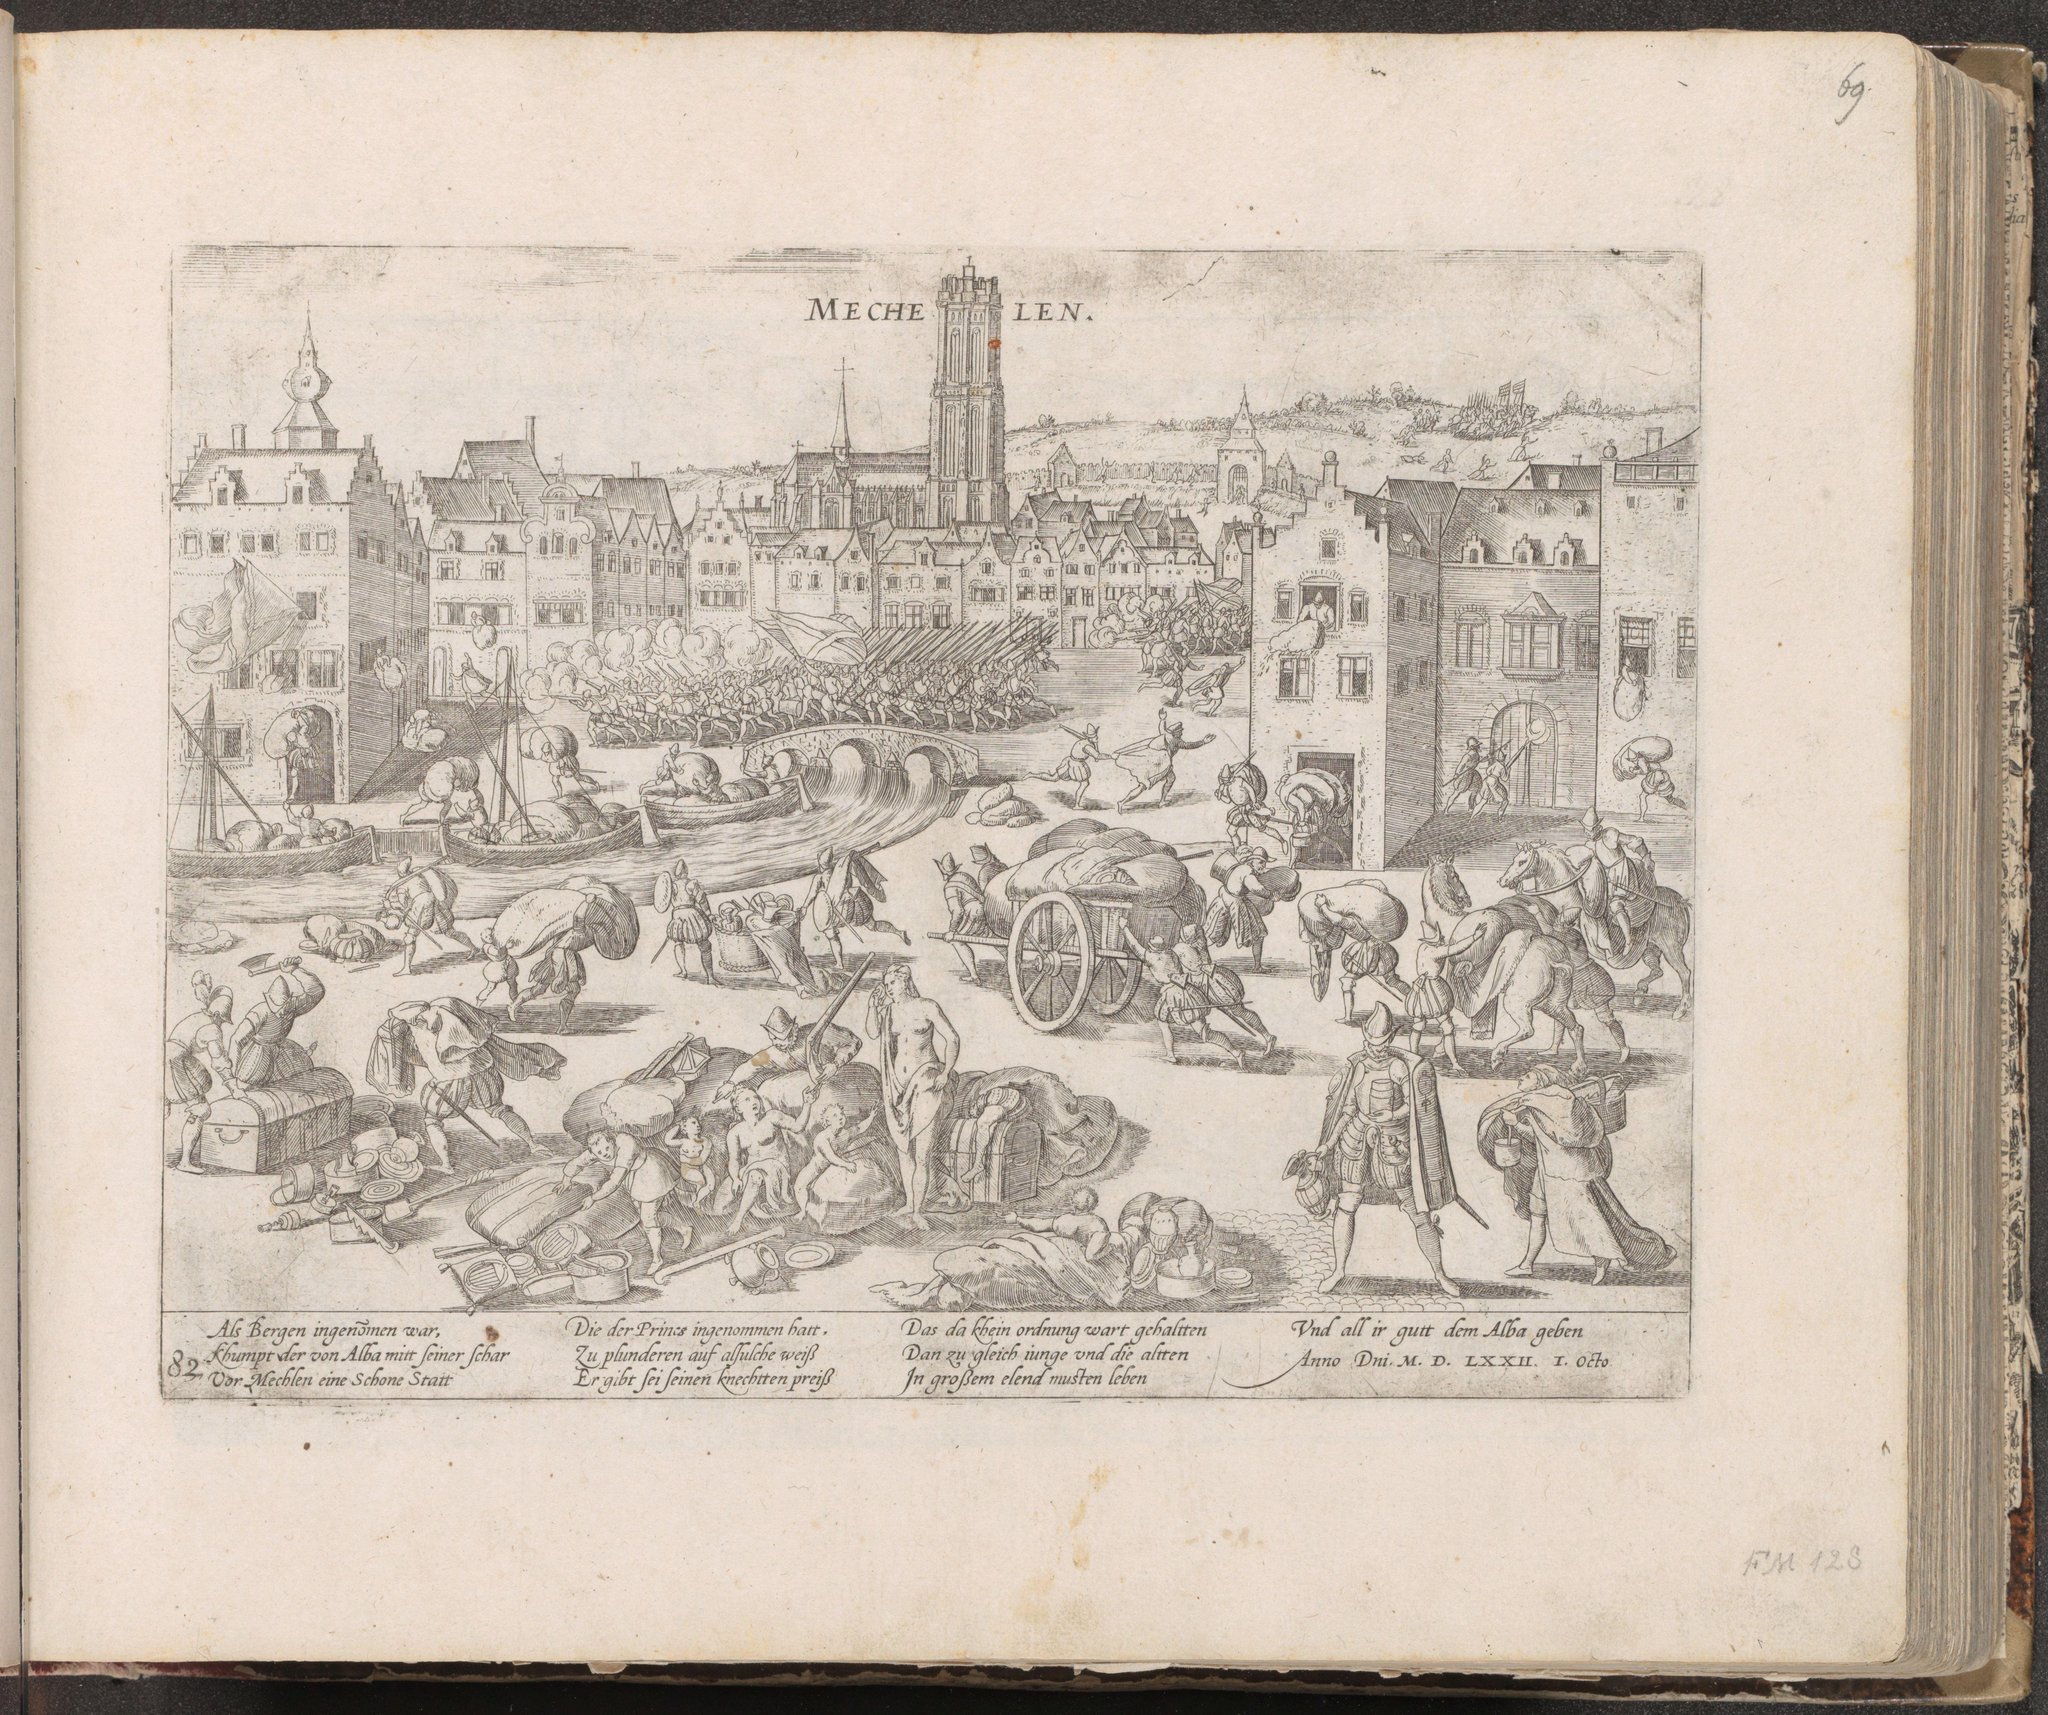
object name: history print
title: Serie 6: Nederlandse Gebeurtenissen, 1571-1576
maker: frans hogenberg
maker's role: print maker, publisher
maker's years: 1538-1590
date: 1574-1578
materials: paper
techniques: etching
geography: cologne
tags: plundering ~ soldiers, mechelen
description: Plundering van Mechelen door het leger van Alva, onder bevel van zijn zoon Don Frederik, 1 oktober 1572. Goederen worden op de markt verzameld en door de soldaten afgevoerd. In het midden op de voorgrond een staande huilende naakte moeder met kinderen. Met onderschrift van 10 regels in het Duits. Linksonder genummerd: 82. De prent maakt deel uit van een album.